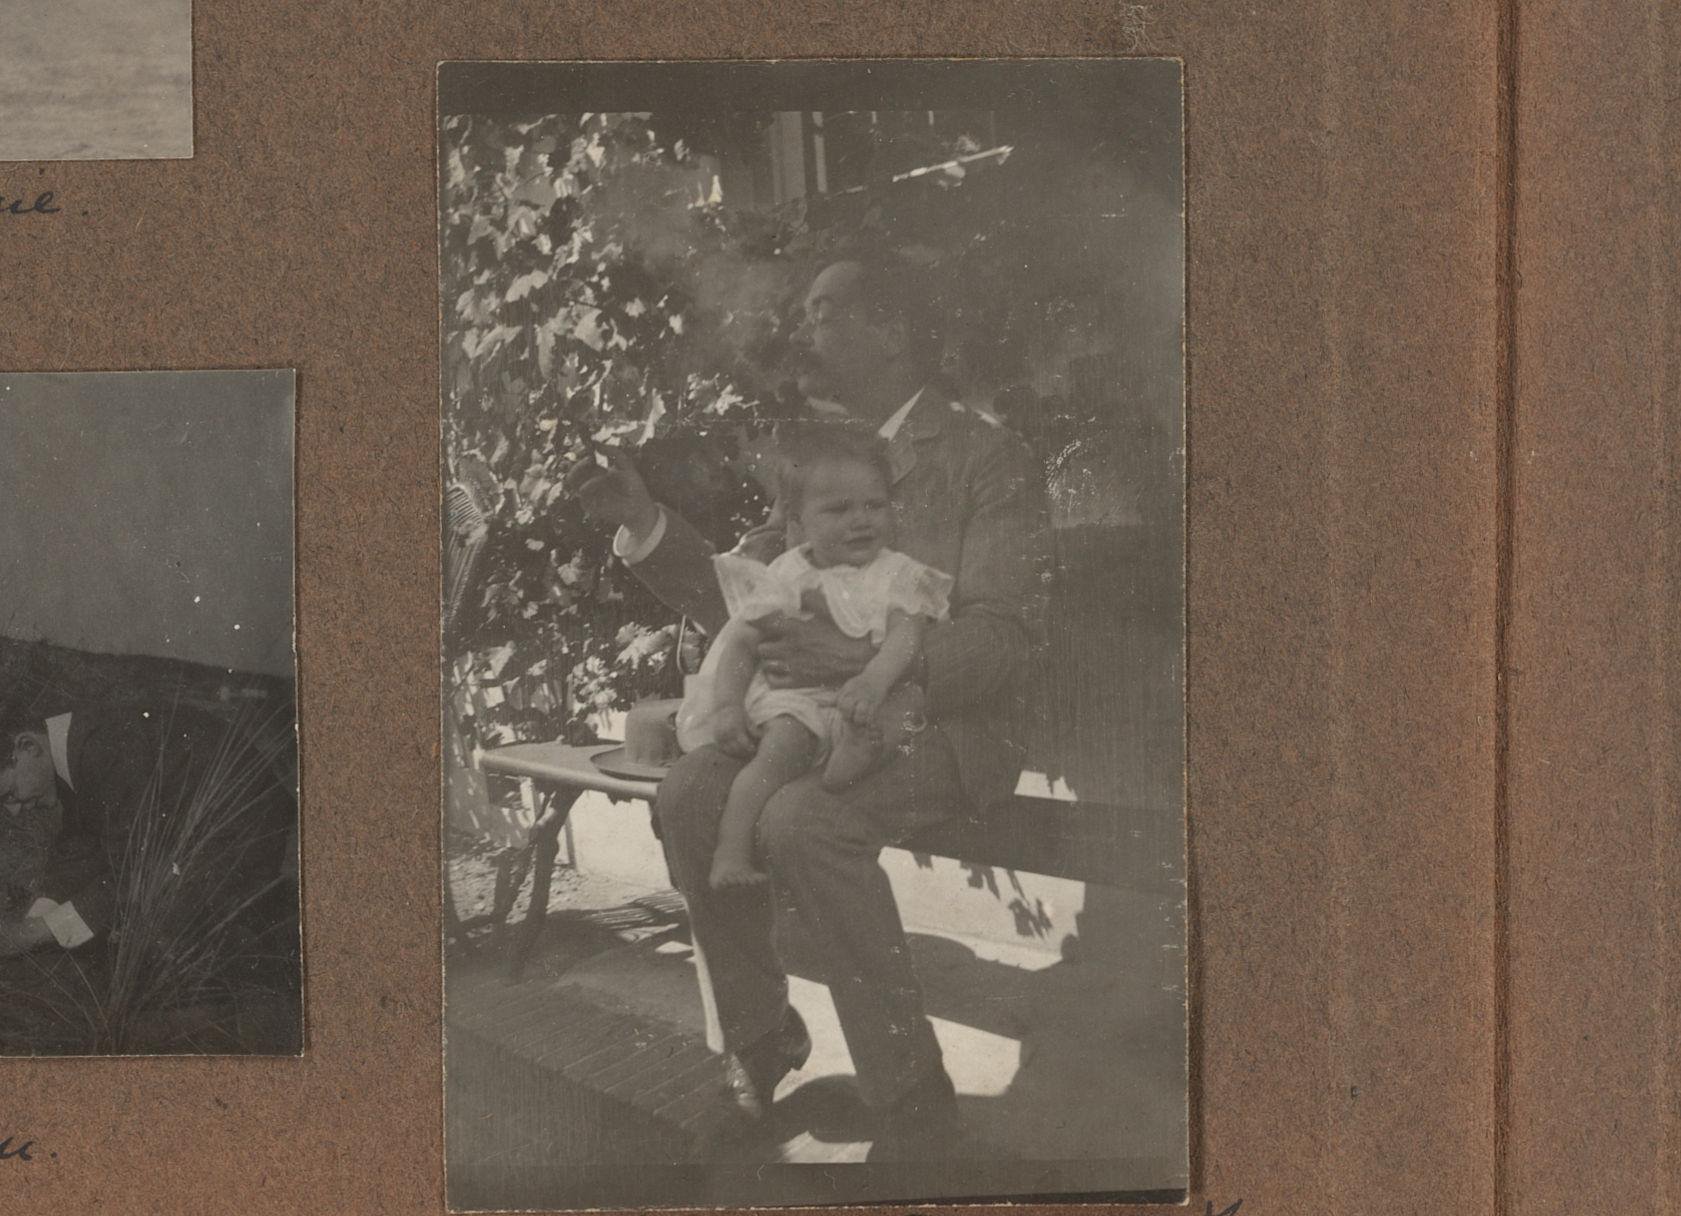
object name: photograph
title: Alphons Diepenbrock en dochter Joanna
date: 1906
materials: photographic support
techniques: photography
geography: netherlands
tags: amsterdam, alphons diepenbrock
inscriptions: inscription: ‘"De Hoeve". Pappie is Jarig / 1906.’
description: Foto op bruin albumblad 26 van familiealbum van Alphons Diepenbrock.